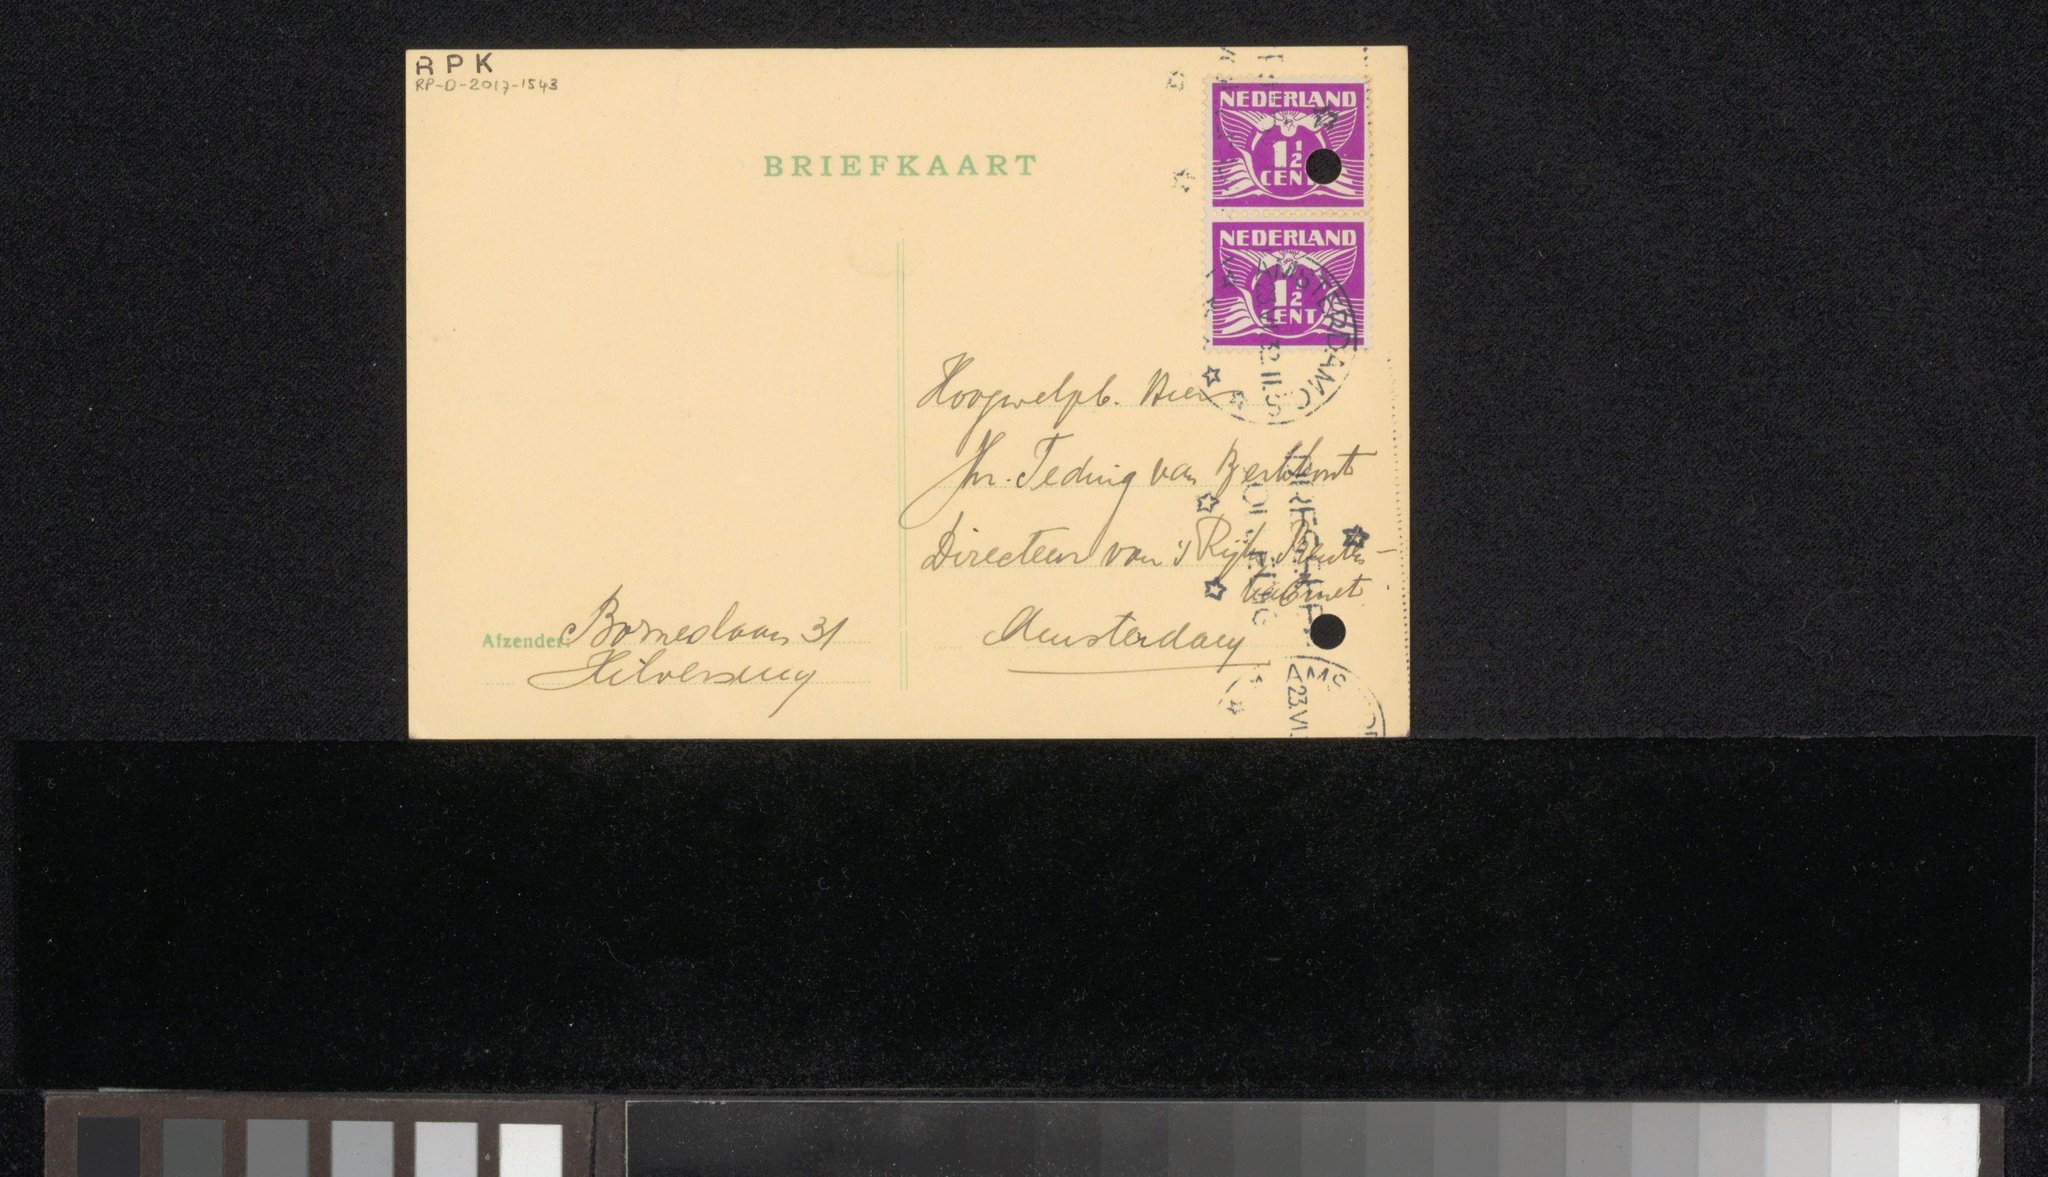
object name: postcard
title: Briefkaart aan jonkheer Hendrik Teding van Berkhout (1879-1969)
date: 1932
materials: cardboard, ink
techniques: pen, writing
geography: hilversum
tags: print room, haarlem, jonkheer hendrik teding van berkhout (1879-1969)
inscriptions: collector's mark: ‘RPK’